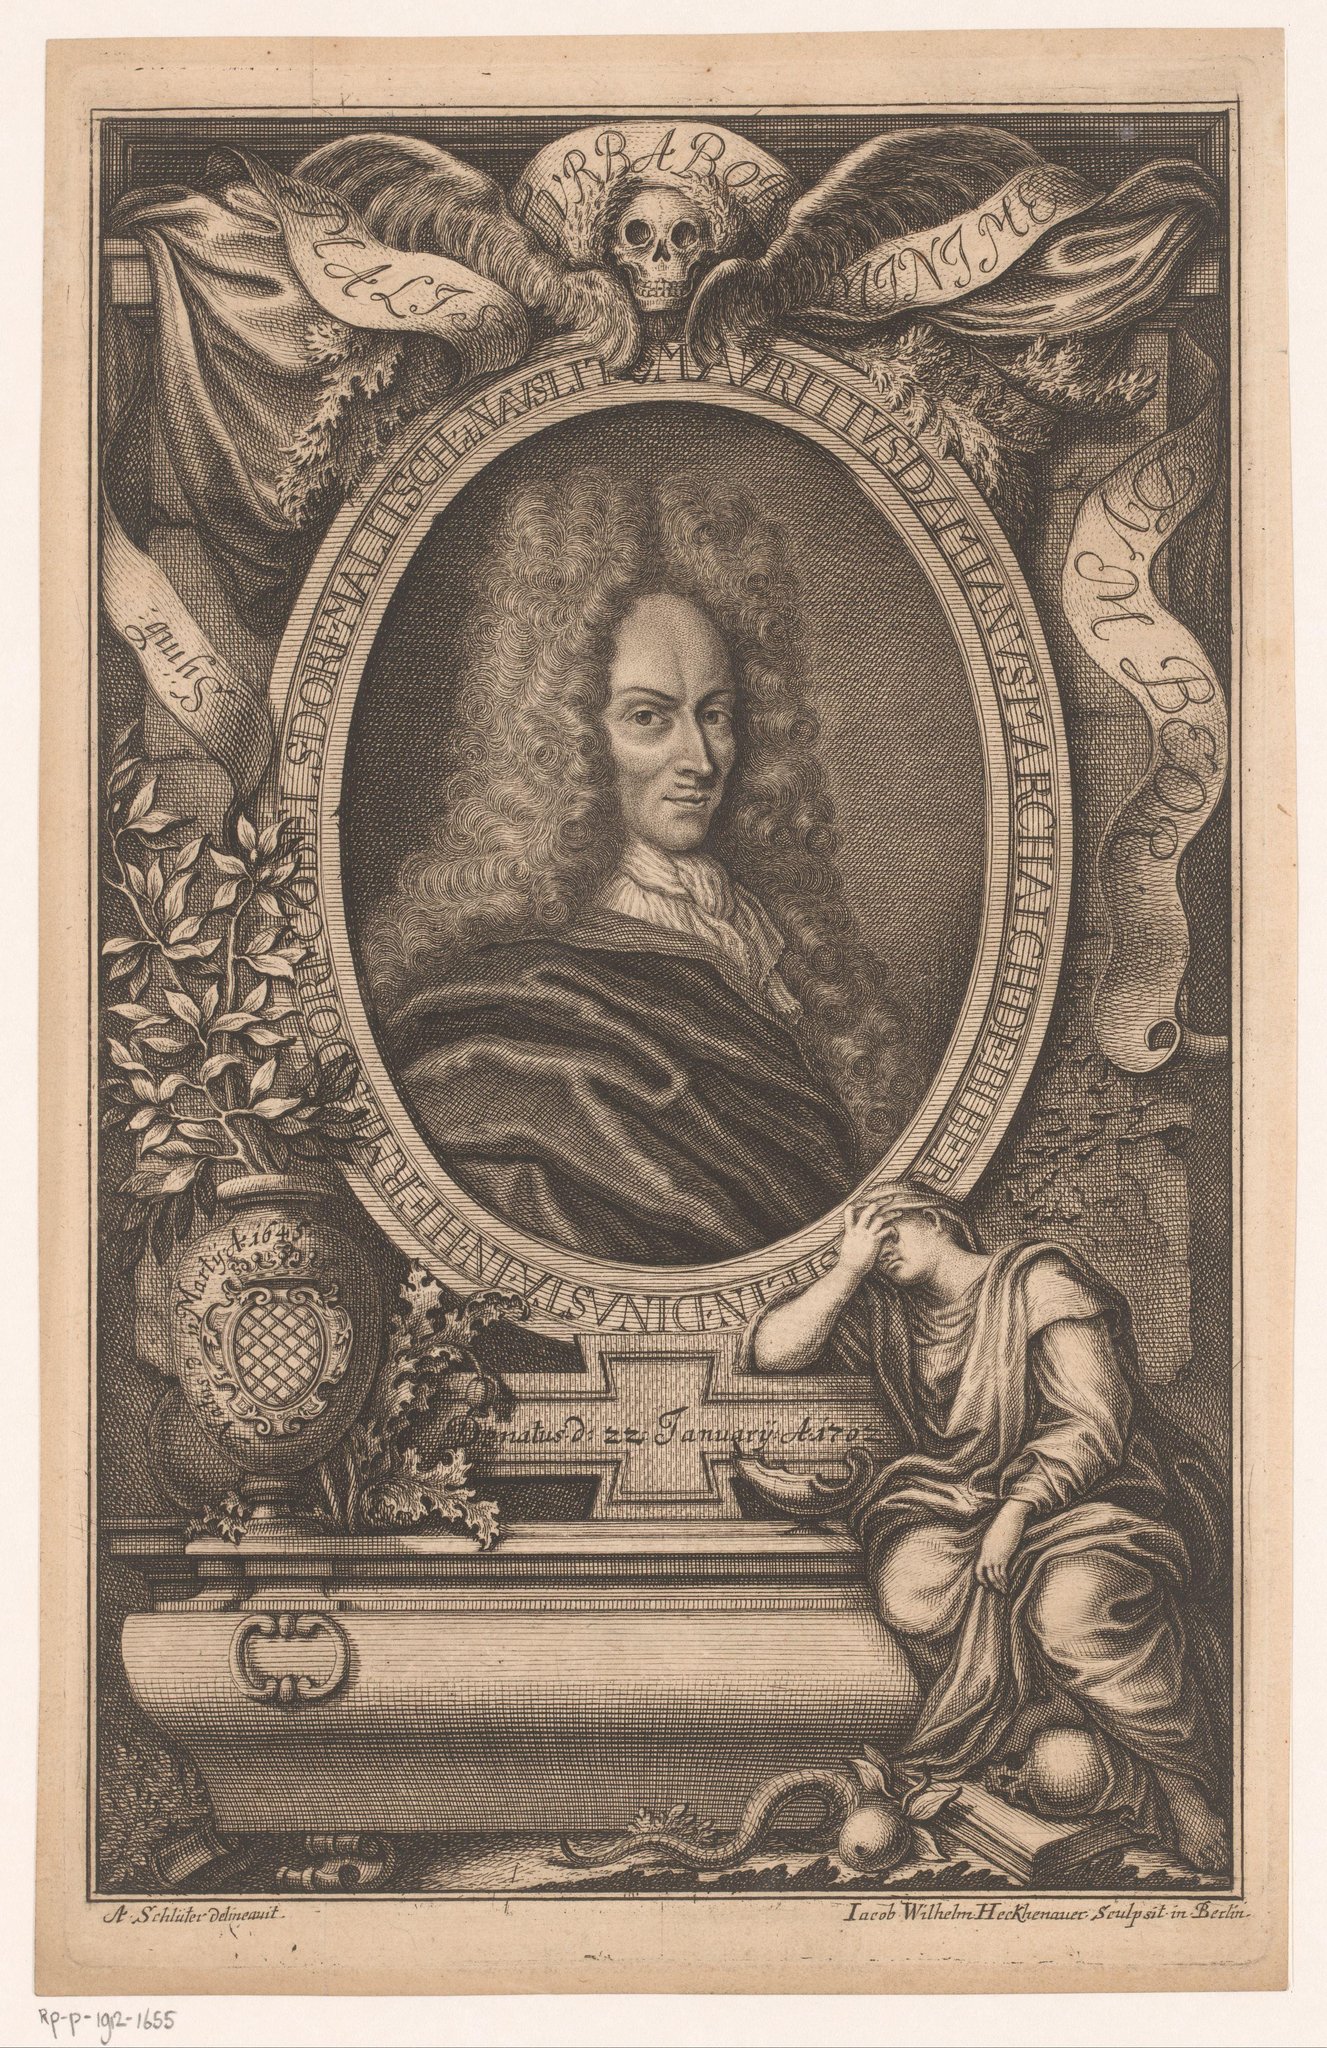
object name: print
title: Portret van Moritz Damian Marschall von Bieberstein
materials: paper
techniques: engraving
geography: berlin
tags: historical persons, symbols of death, armorial bearing, heraldry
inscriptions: collector's mark: Lugt 2228